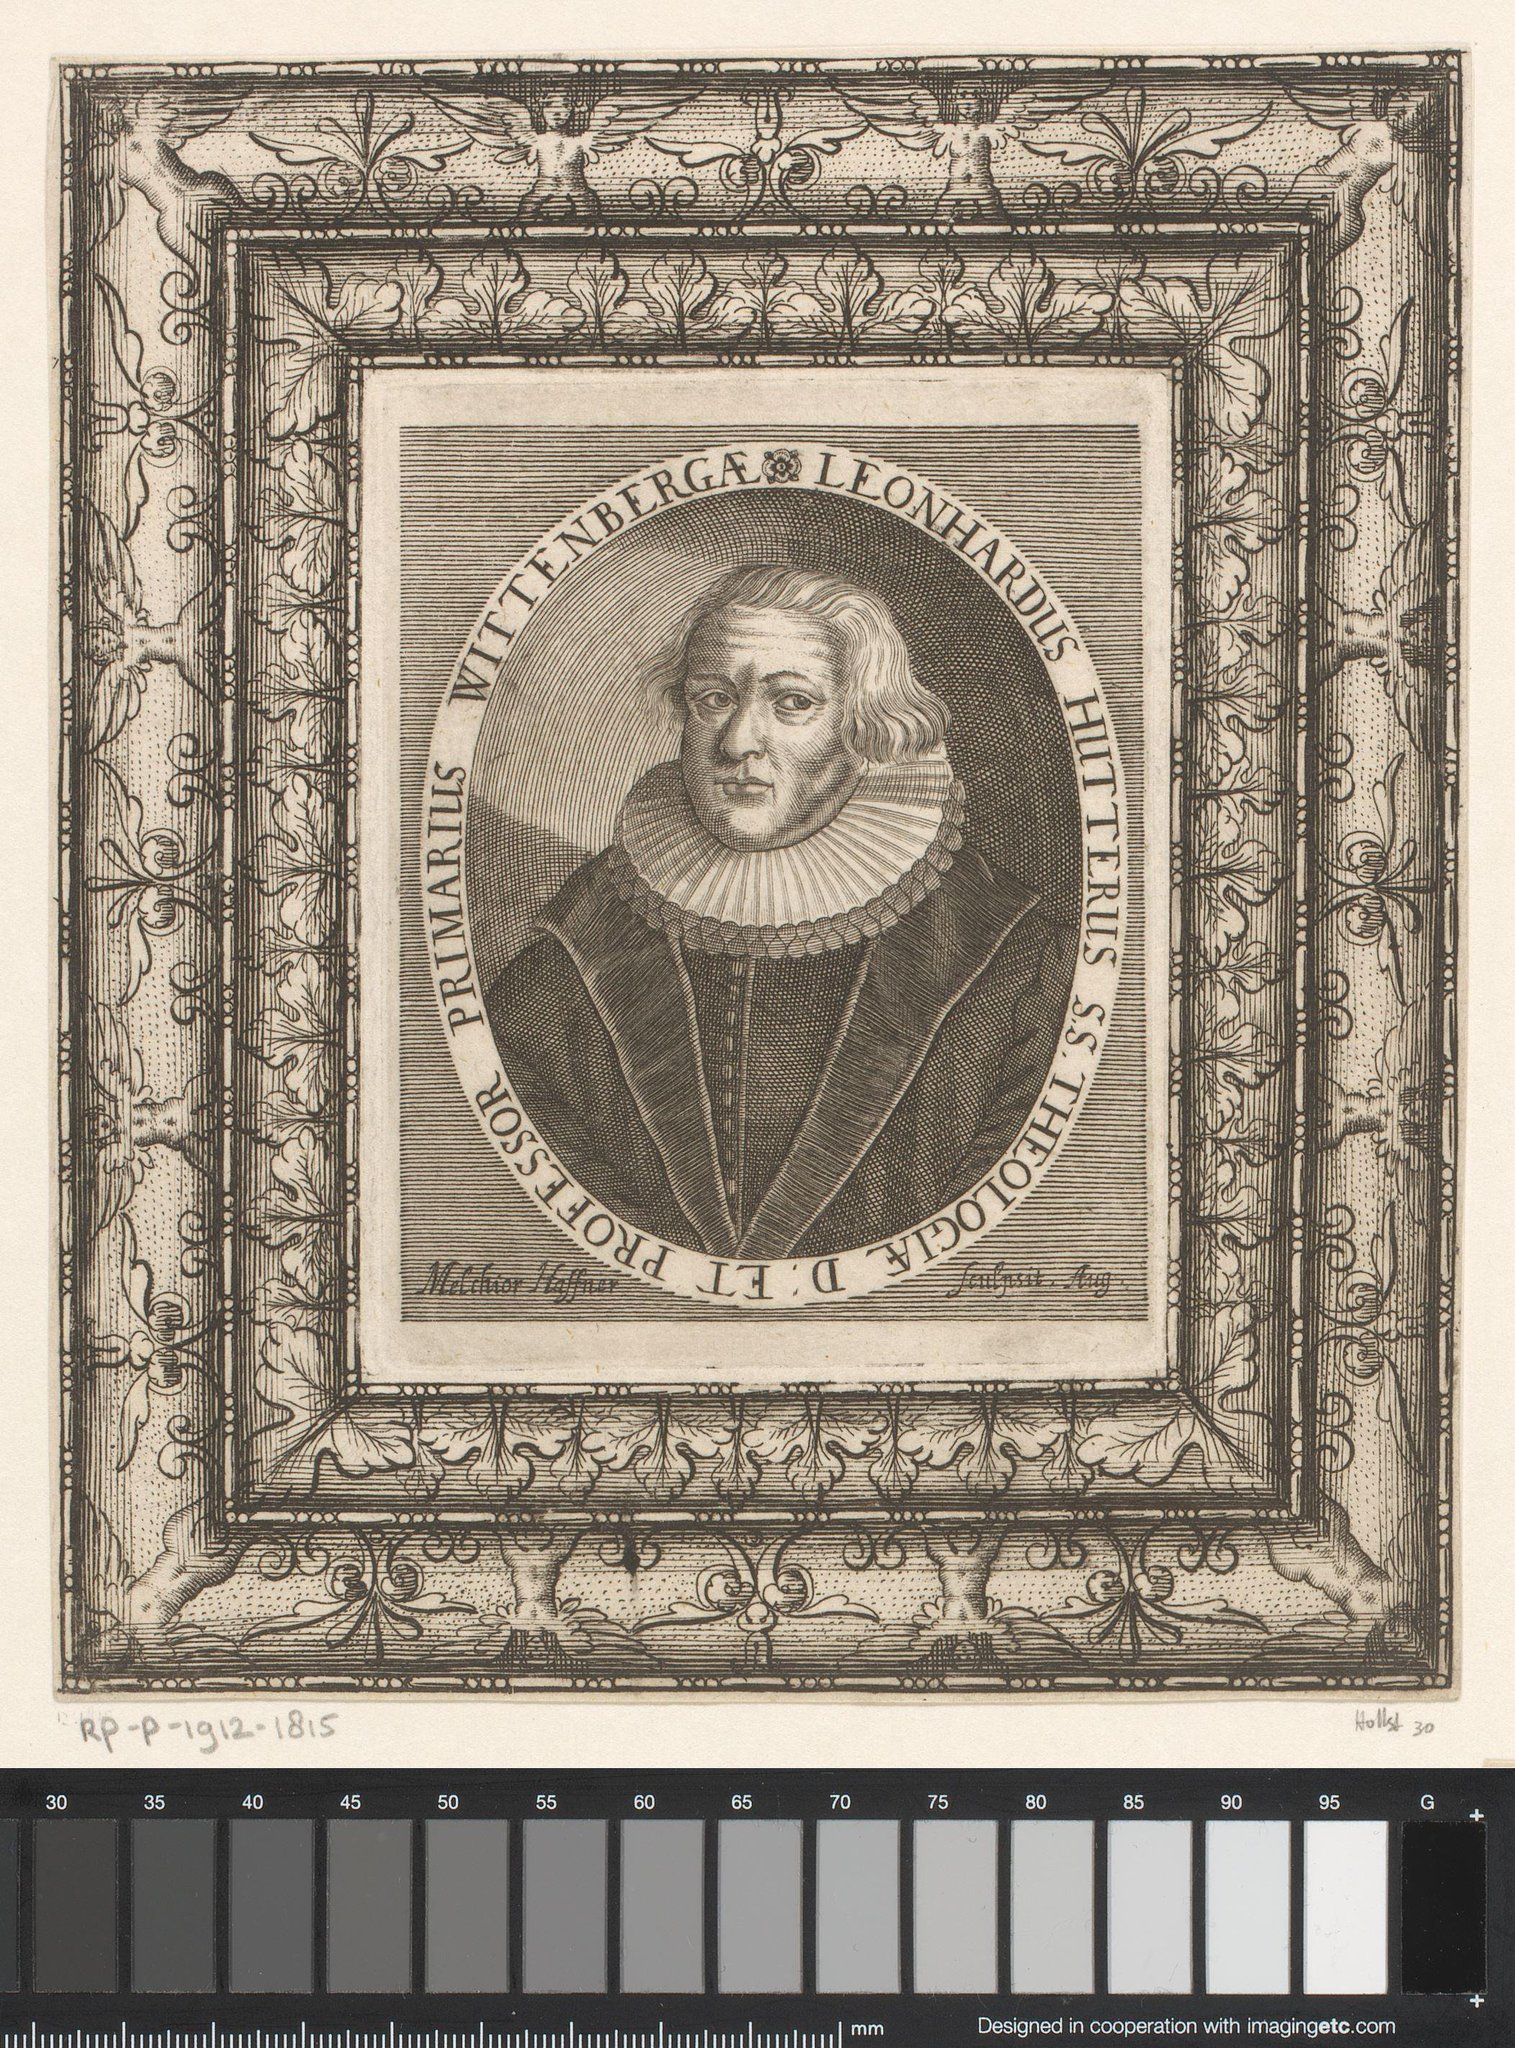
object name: book illustration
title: Leonhardus Hutterus (...)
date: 1673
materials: paper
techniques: engraving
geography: augsburg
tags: theologian, historical persons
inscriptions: collector's mark: Lugt 2228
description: Prent ook gebruikt in: Spizel, Gottlieb. Templum honoris reseratum (...). Augsburg: Gottlieb Göbel, 1673. In de publicatie is het portret gedrukt zonder omlijsting.